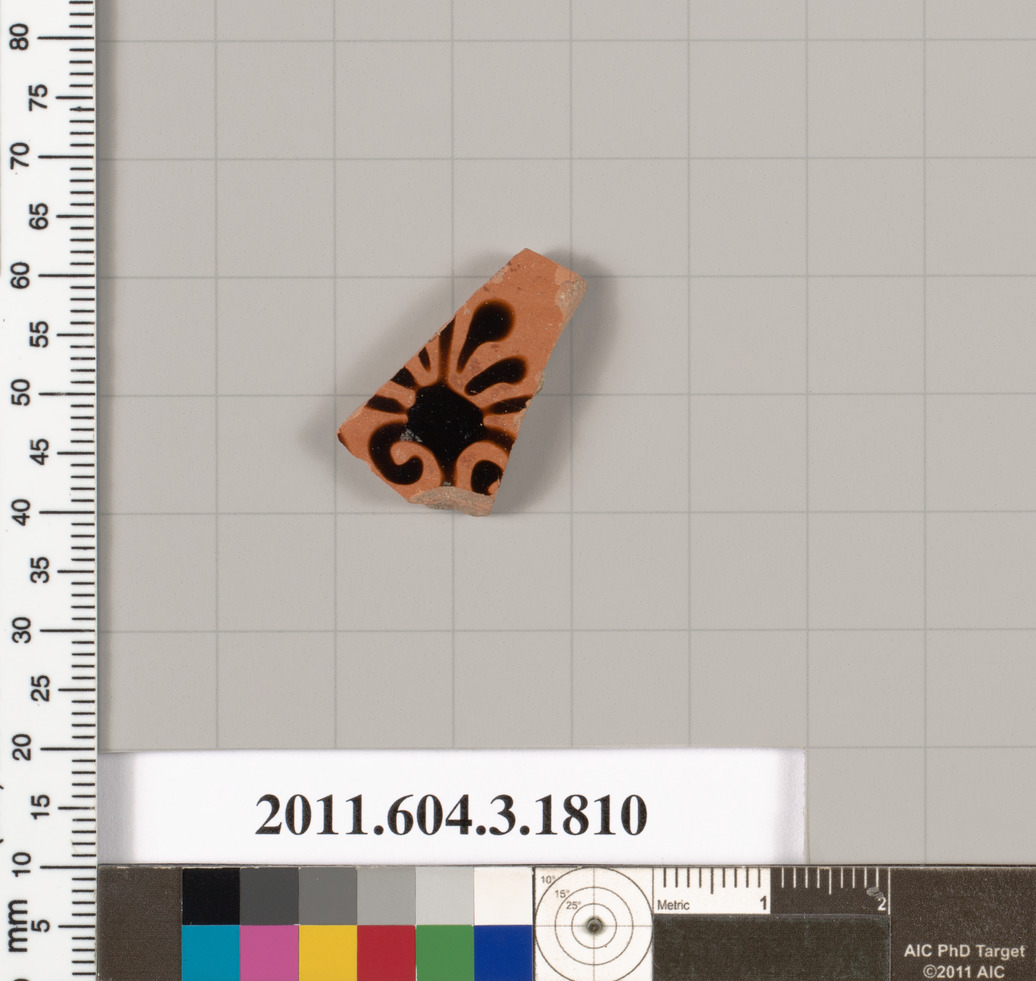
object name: kylix fragment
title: Terracotta fragment of a kylix: Lip cup (drinking cup)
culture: greek, attic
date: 550-526 BCE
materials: terracotta